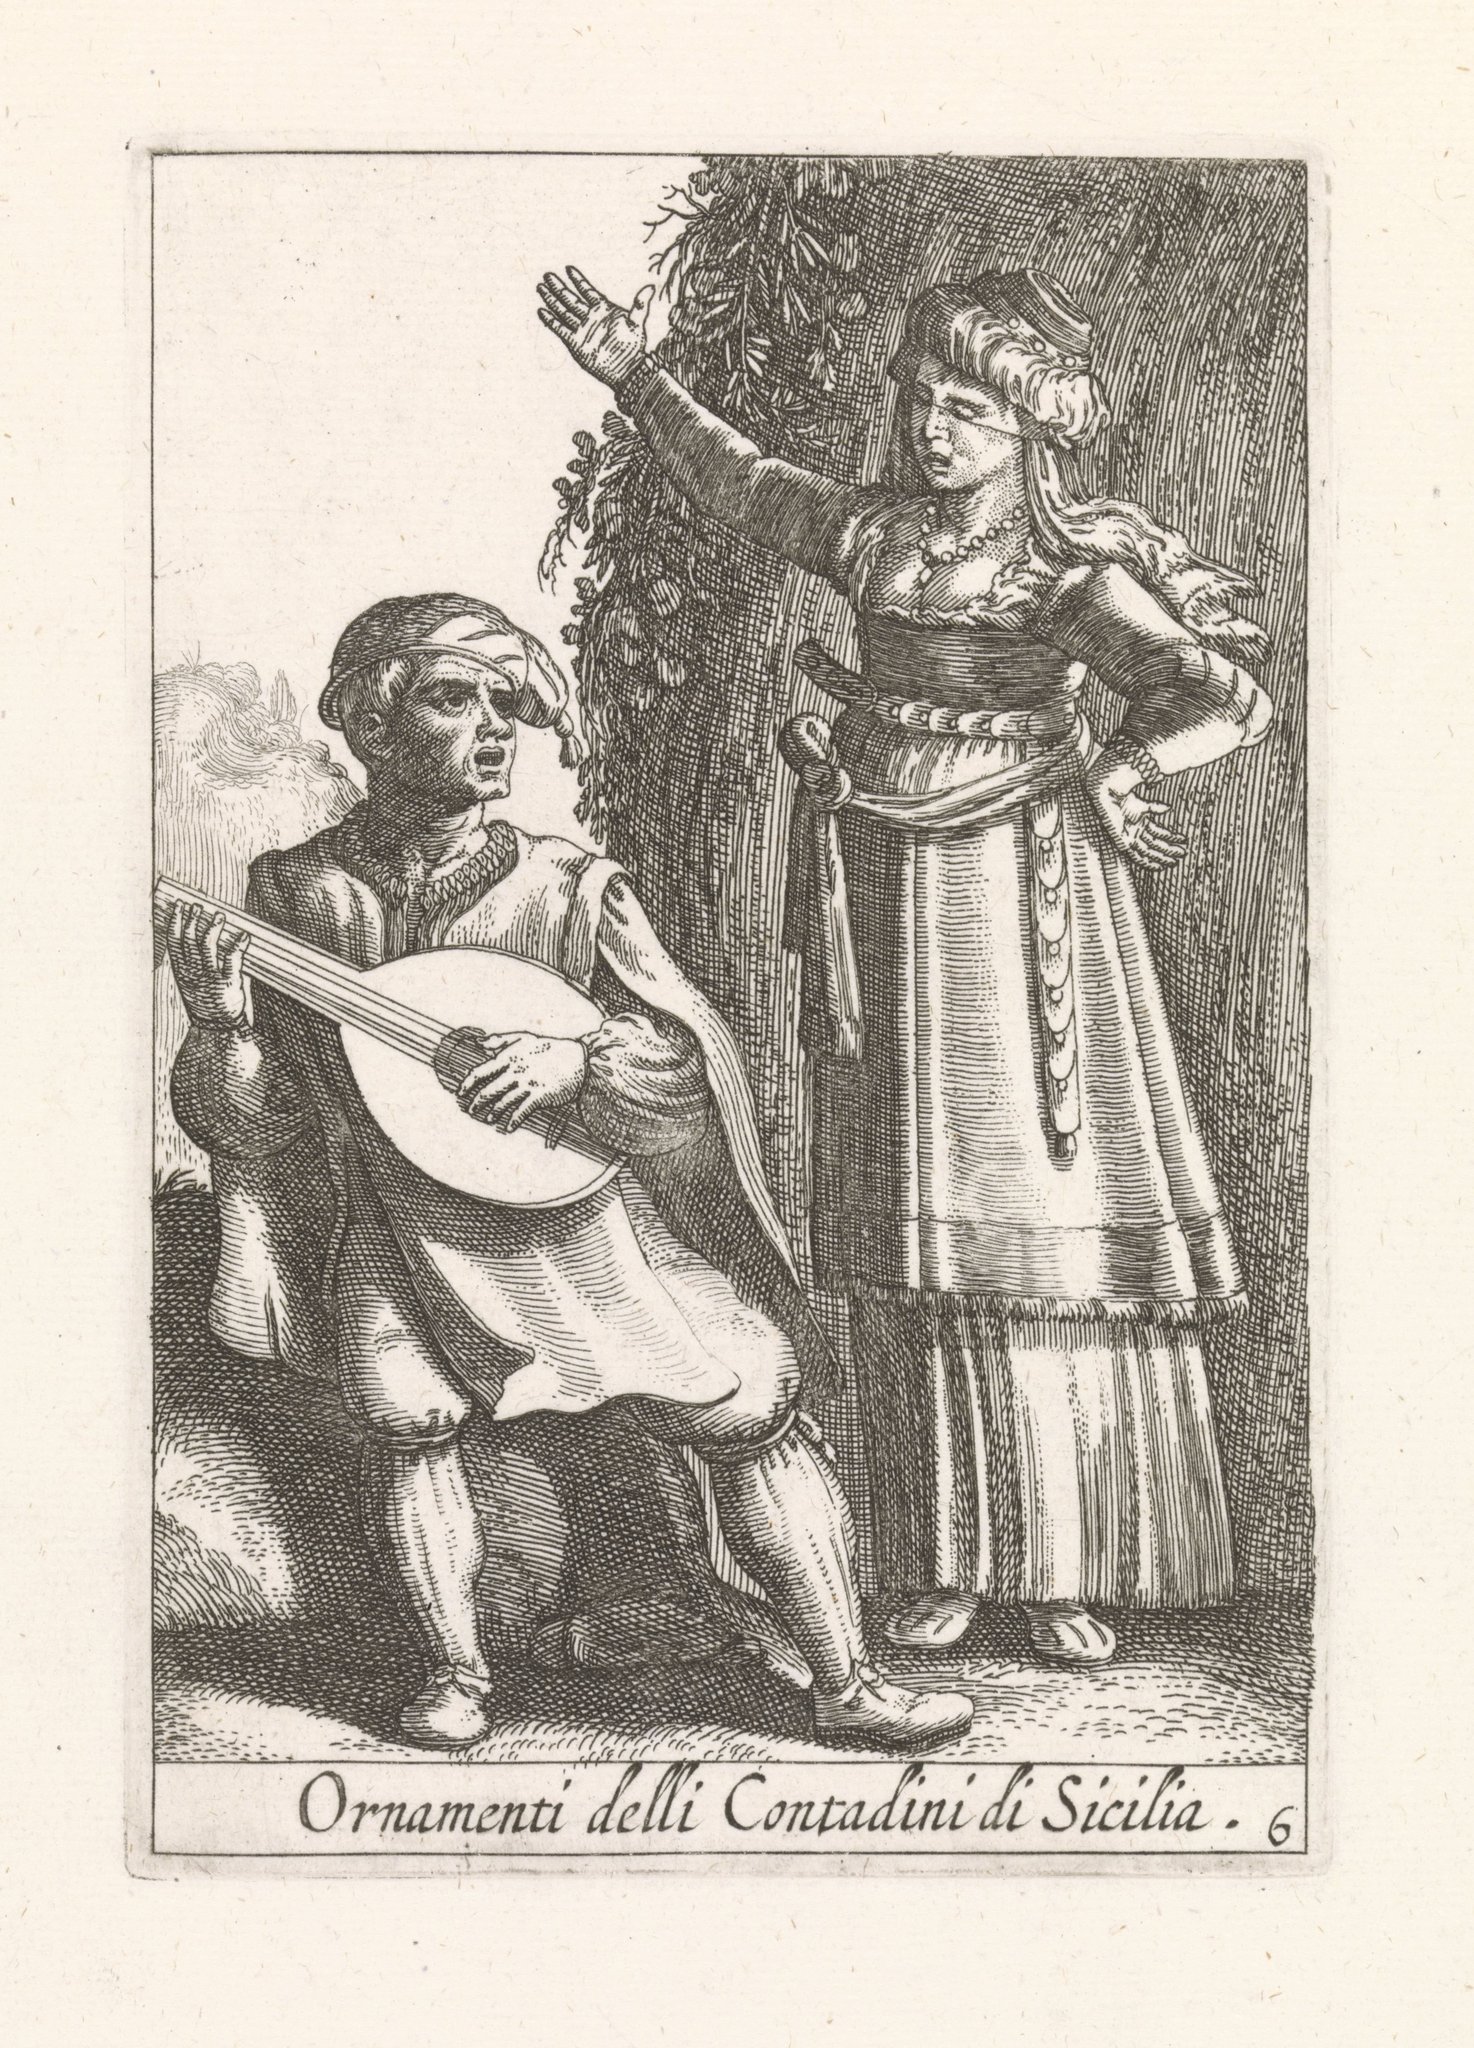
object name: print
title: Kostuums uit Italië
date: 1720-1772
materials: paper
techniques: etching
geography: amsterdam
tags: musician(s) accompanying singer(s), europeans (with name) (+ costume)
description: Een boerenpaar gekleed in mode uit Sicilië, Italië. Het paar is ten voeten uit weergegeven. De zittende man bespeelt de luit, zijn hoofd is getooid met een baret. Hij begeleidt de zingende vrouw die naast hem staat. De vrouw draagt een japon met riem, haar hoofd is gedeeltelijk bedekt met een klein hoofddeksel waaraan een sluier is bevestigd. De prent maakt deel uit van een twaalfdelige serie prenten met Italiaanse kostuums.